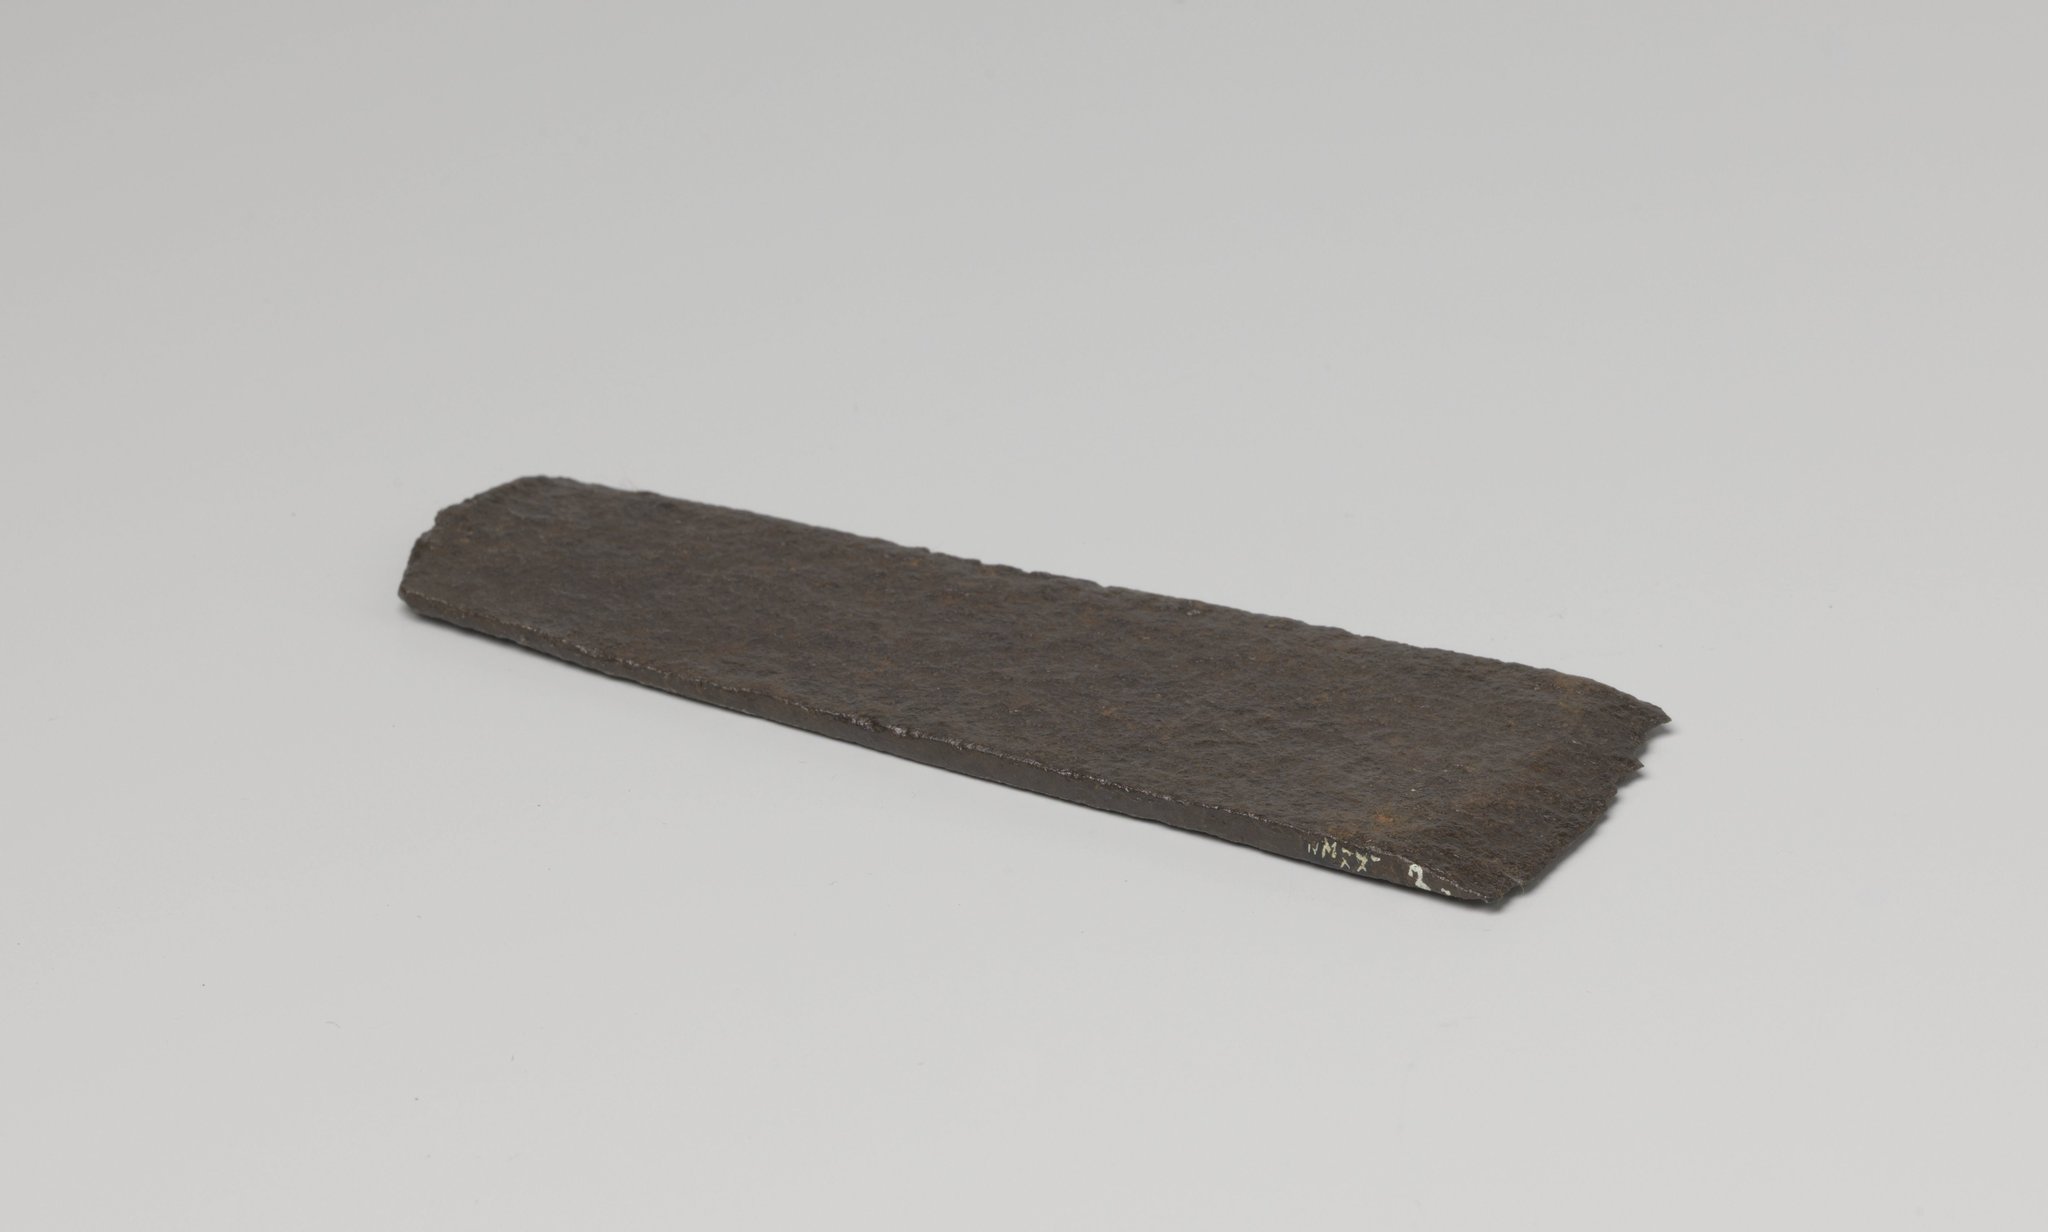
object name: plane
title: Schaafbeitel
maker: Anonymous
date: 1590-1596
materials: iron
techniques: forging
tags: willem barendsz., amsterdam, jacob van heemskerck